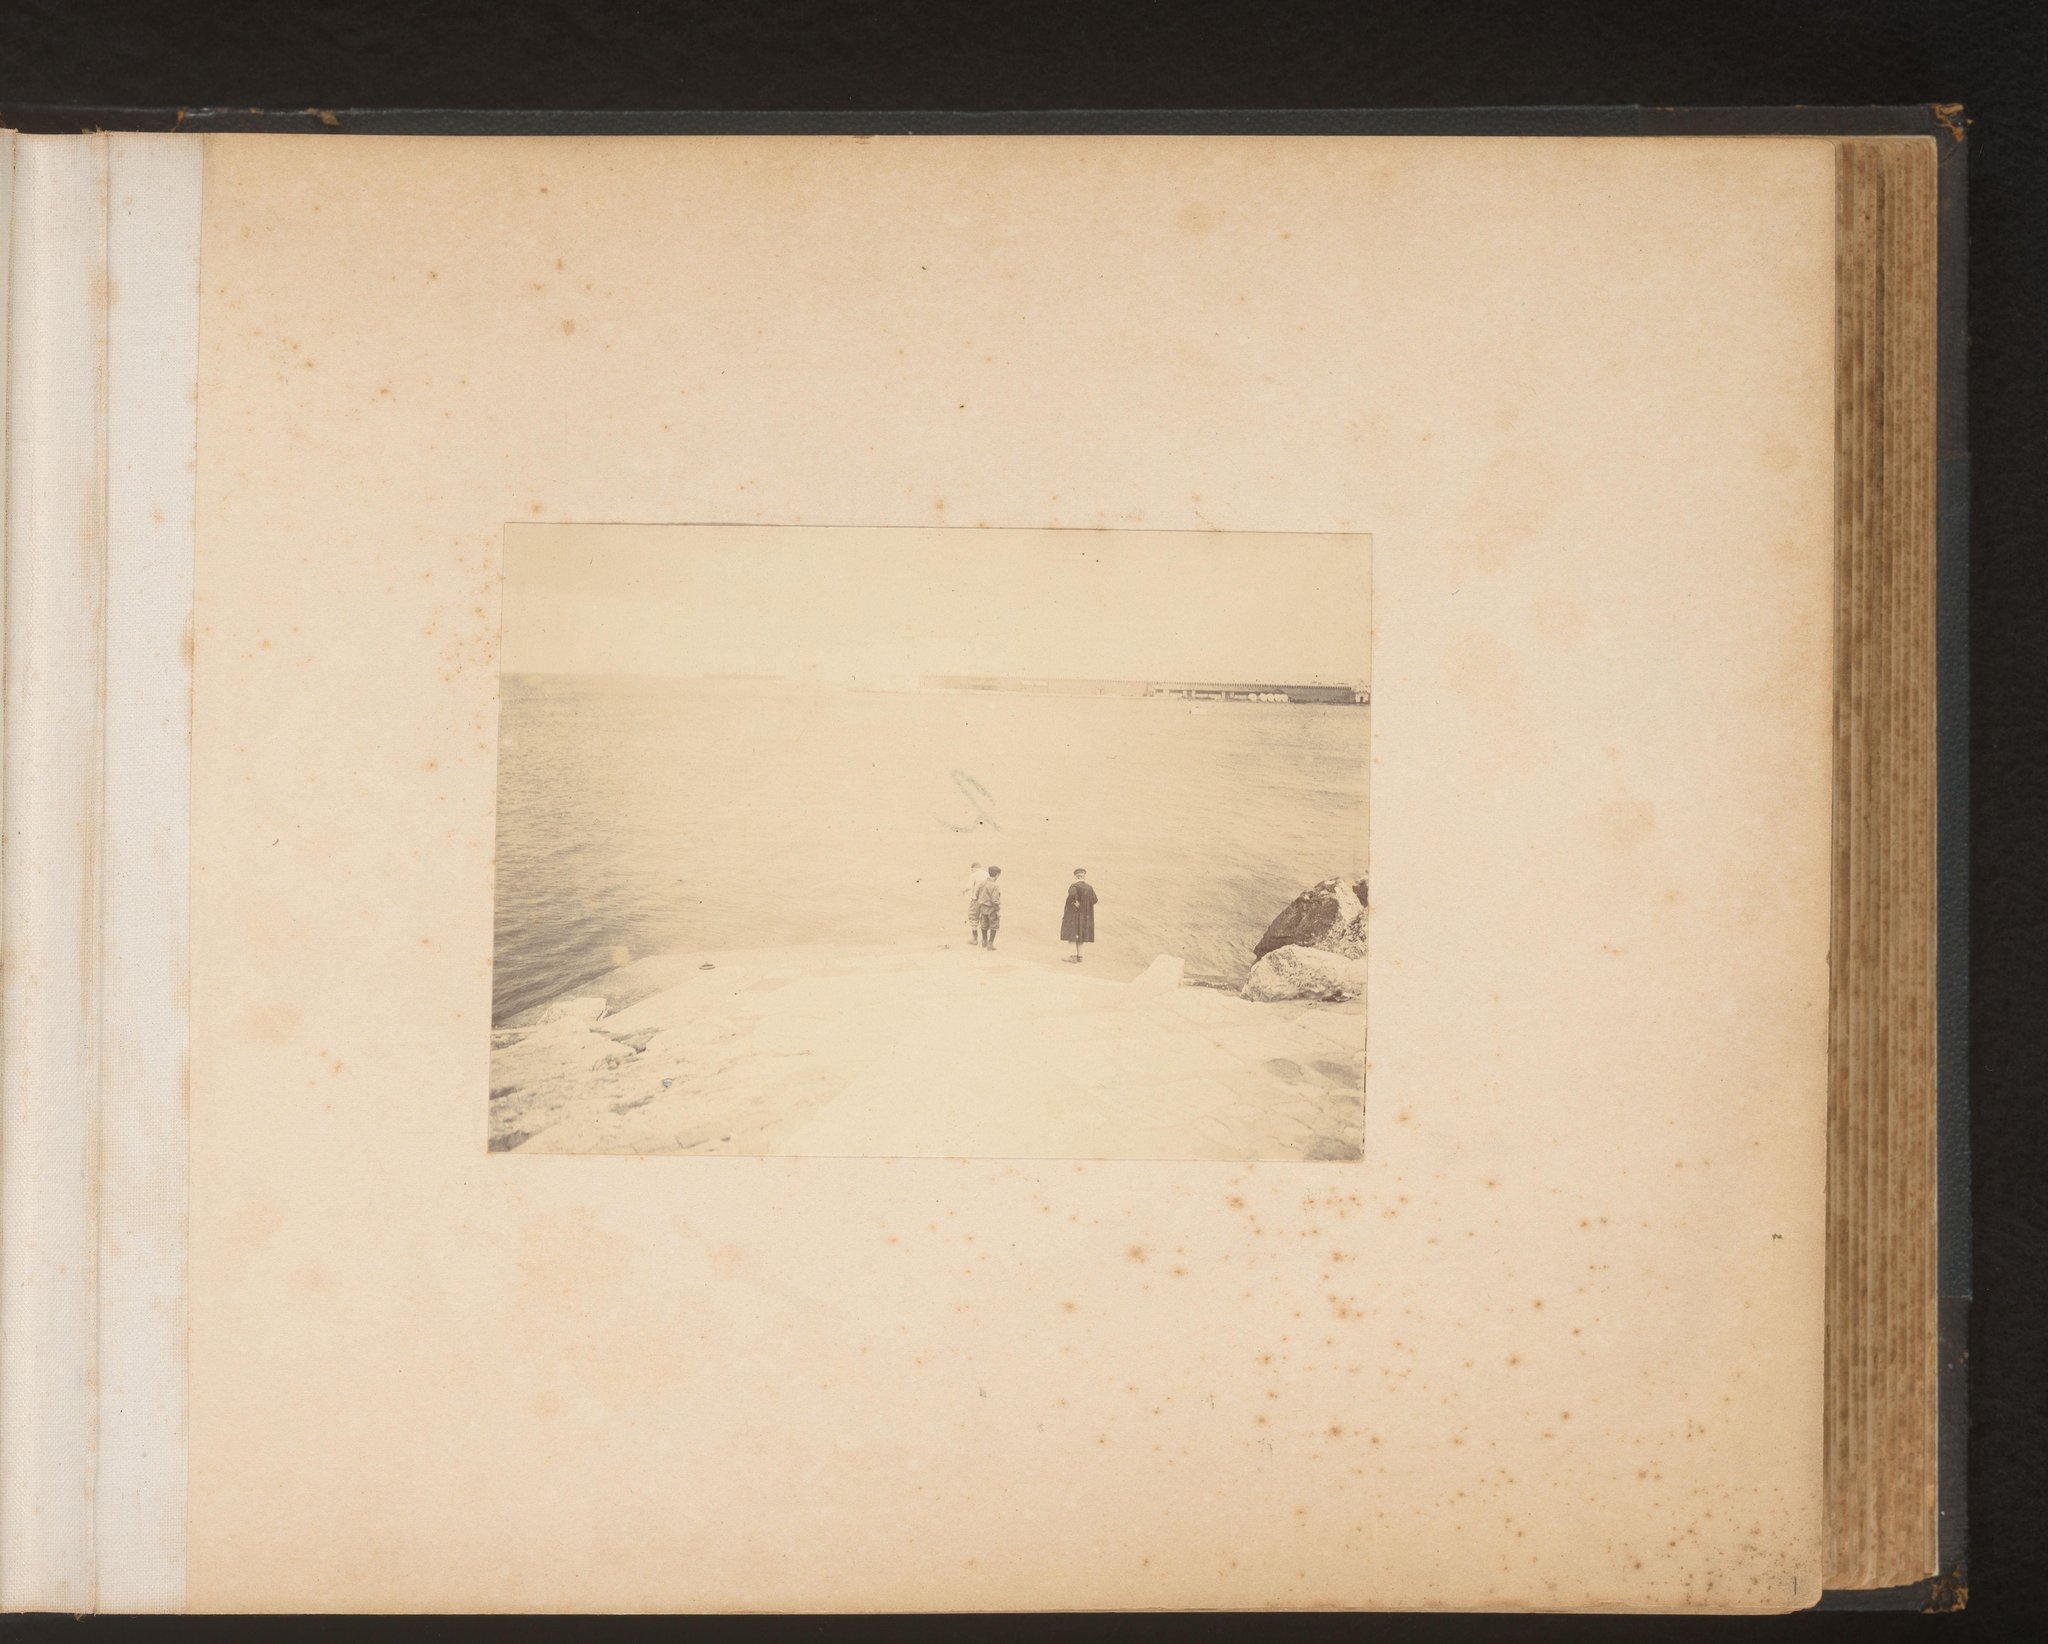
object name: album leaf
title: Drie personen aan de kust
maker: Anonymous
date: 1880-1920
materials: cardboard, photographic support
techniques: gelatin silver print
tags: historical persons, coast, france